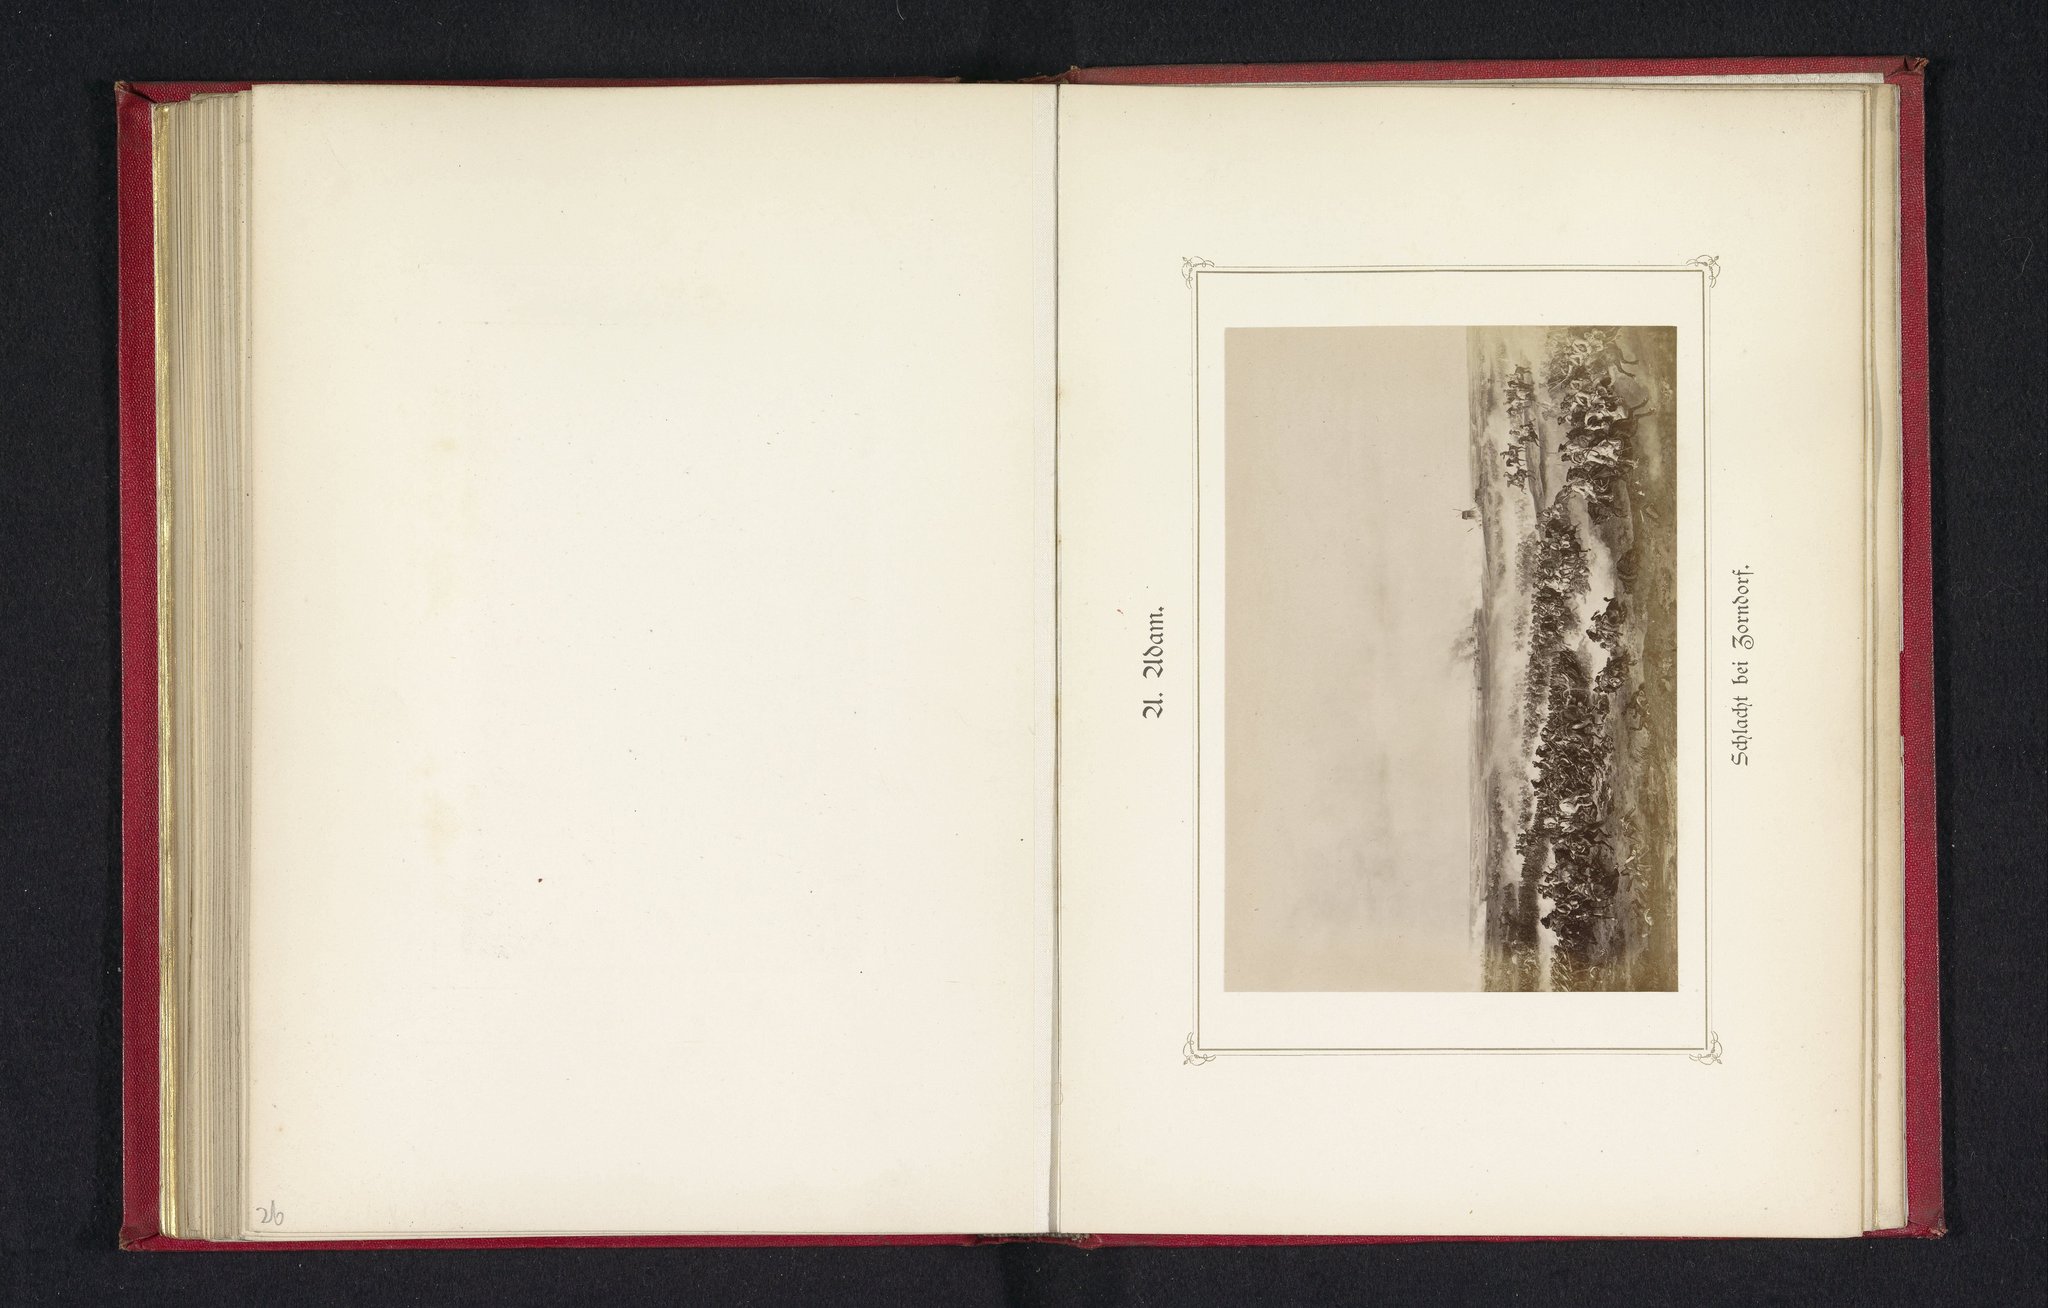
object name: page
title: Fotoreproductie van een schilderij, voorstellende Slag bij Zorndorff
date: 1875-1880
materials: photographic support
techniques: albumen print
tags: battle